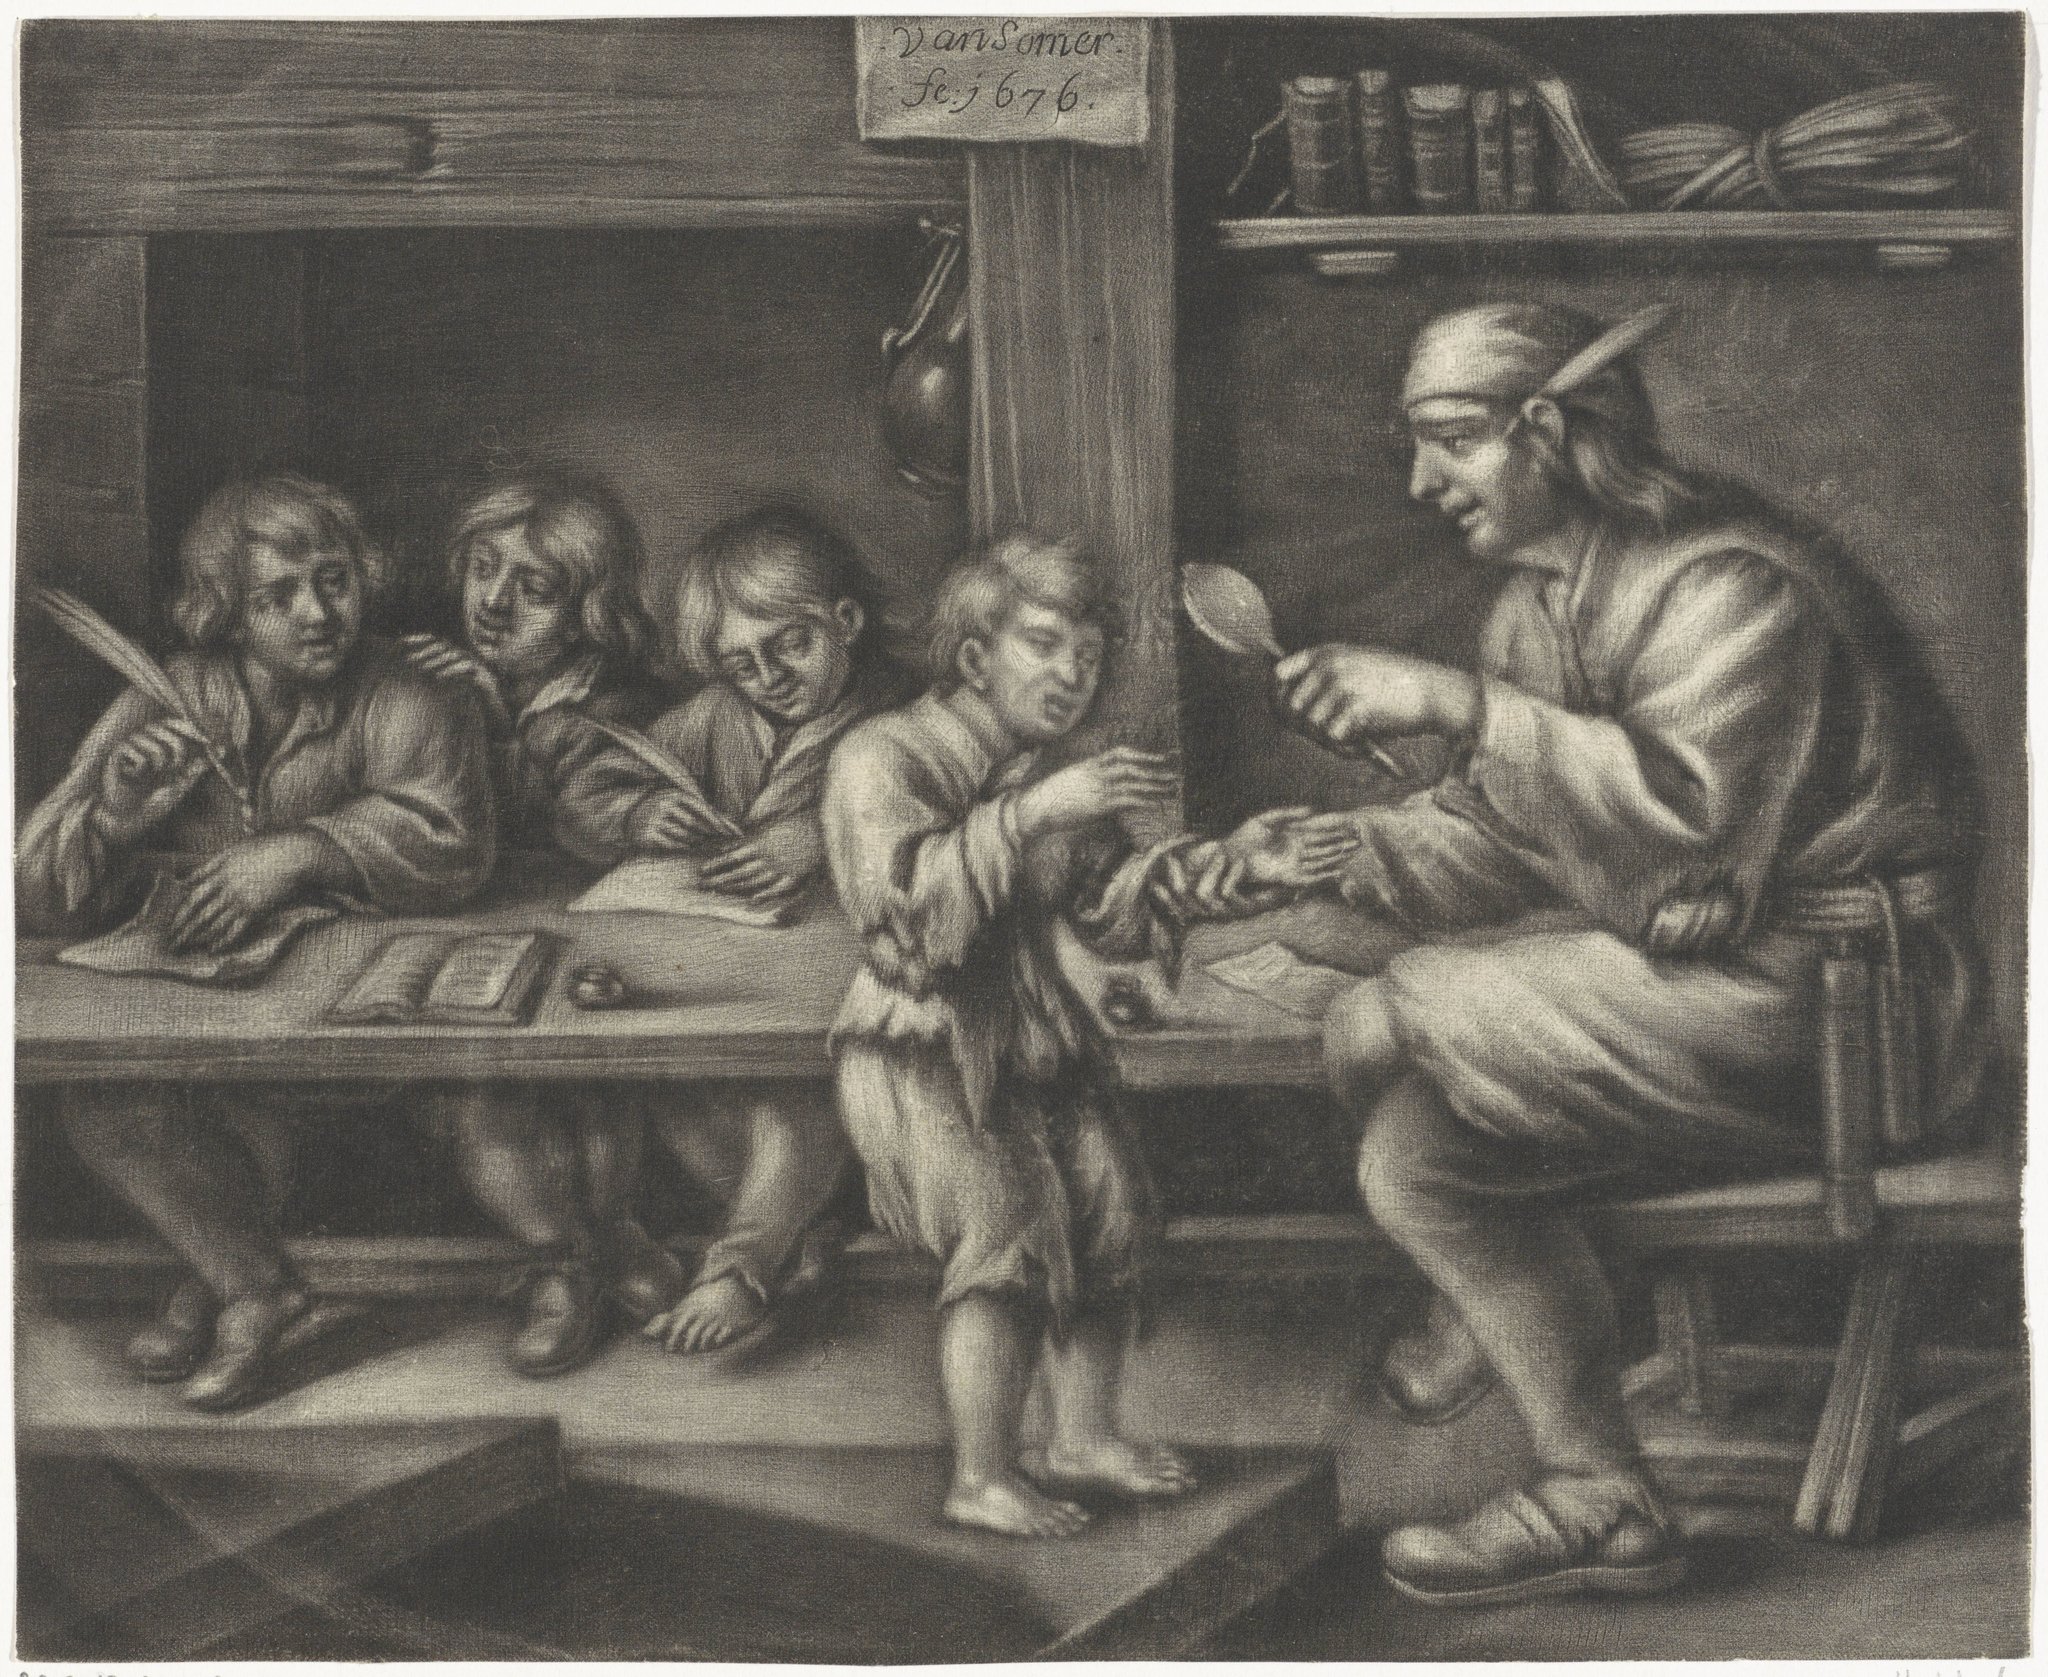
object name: print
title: Schoolmeester geeft een jongen de plak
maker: jan van somer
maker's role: draughtsman, print maker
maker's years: 1645-1699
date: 1676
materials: paper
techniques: mezzotint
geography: amsterdam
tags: quill, teacher and pupil, punishment at school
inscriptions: collector's mark: Lugt 2228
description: Een schoolmeester geeft een jongen de plak in het bijzijn van drie andere leerlingen. In het klaslokaal liggen boeken en schrijfveren.